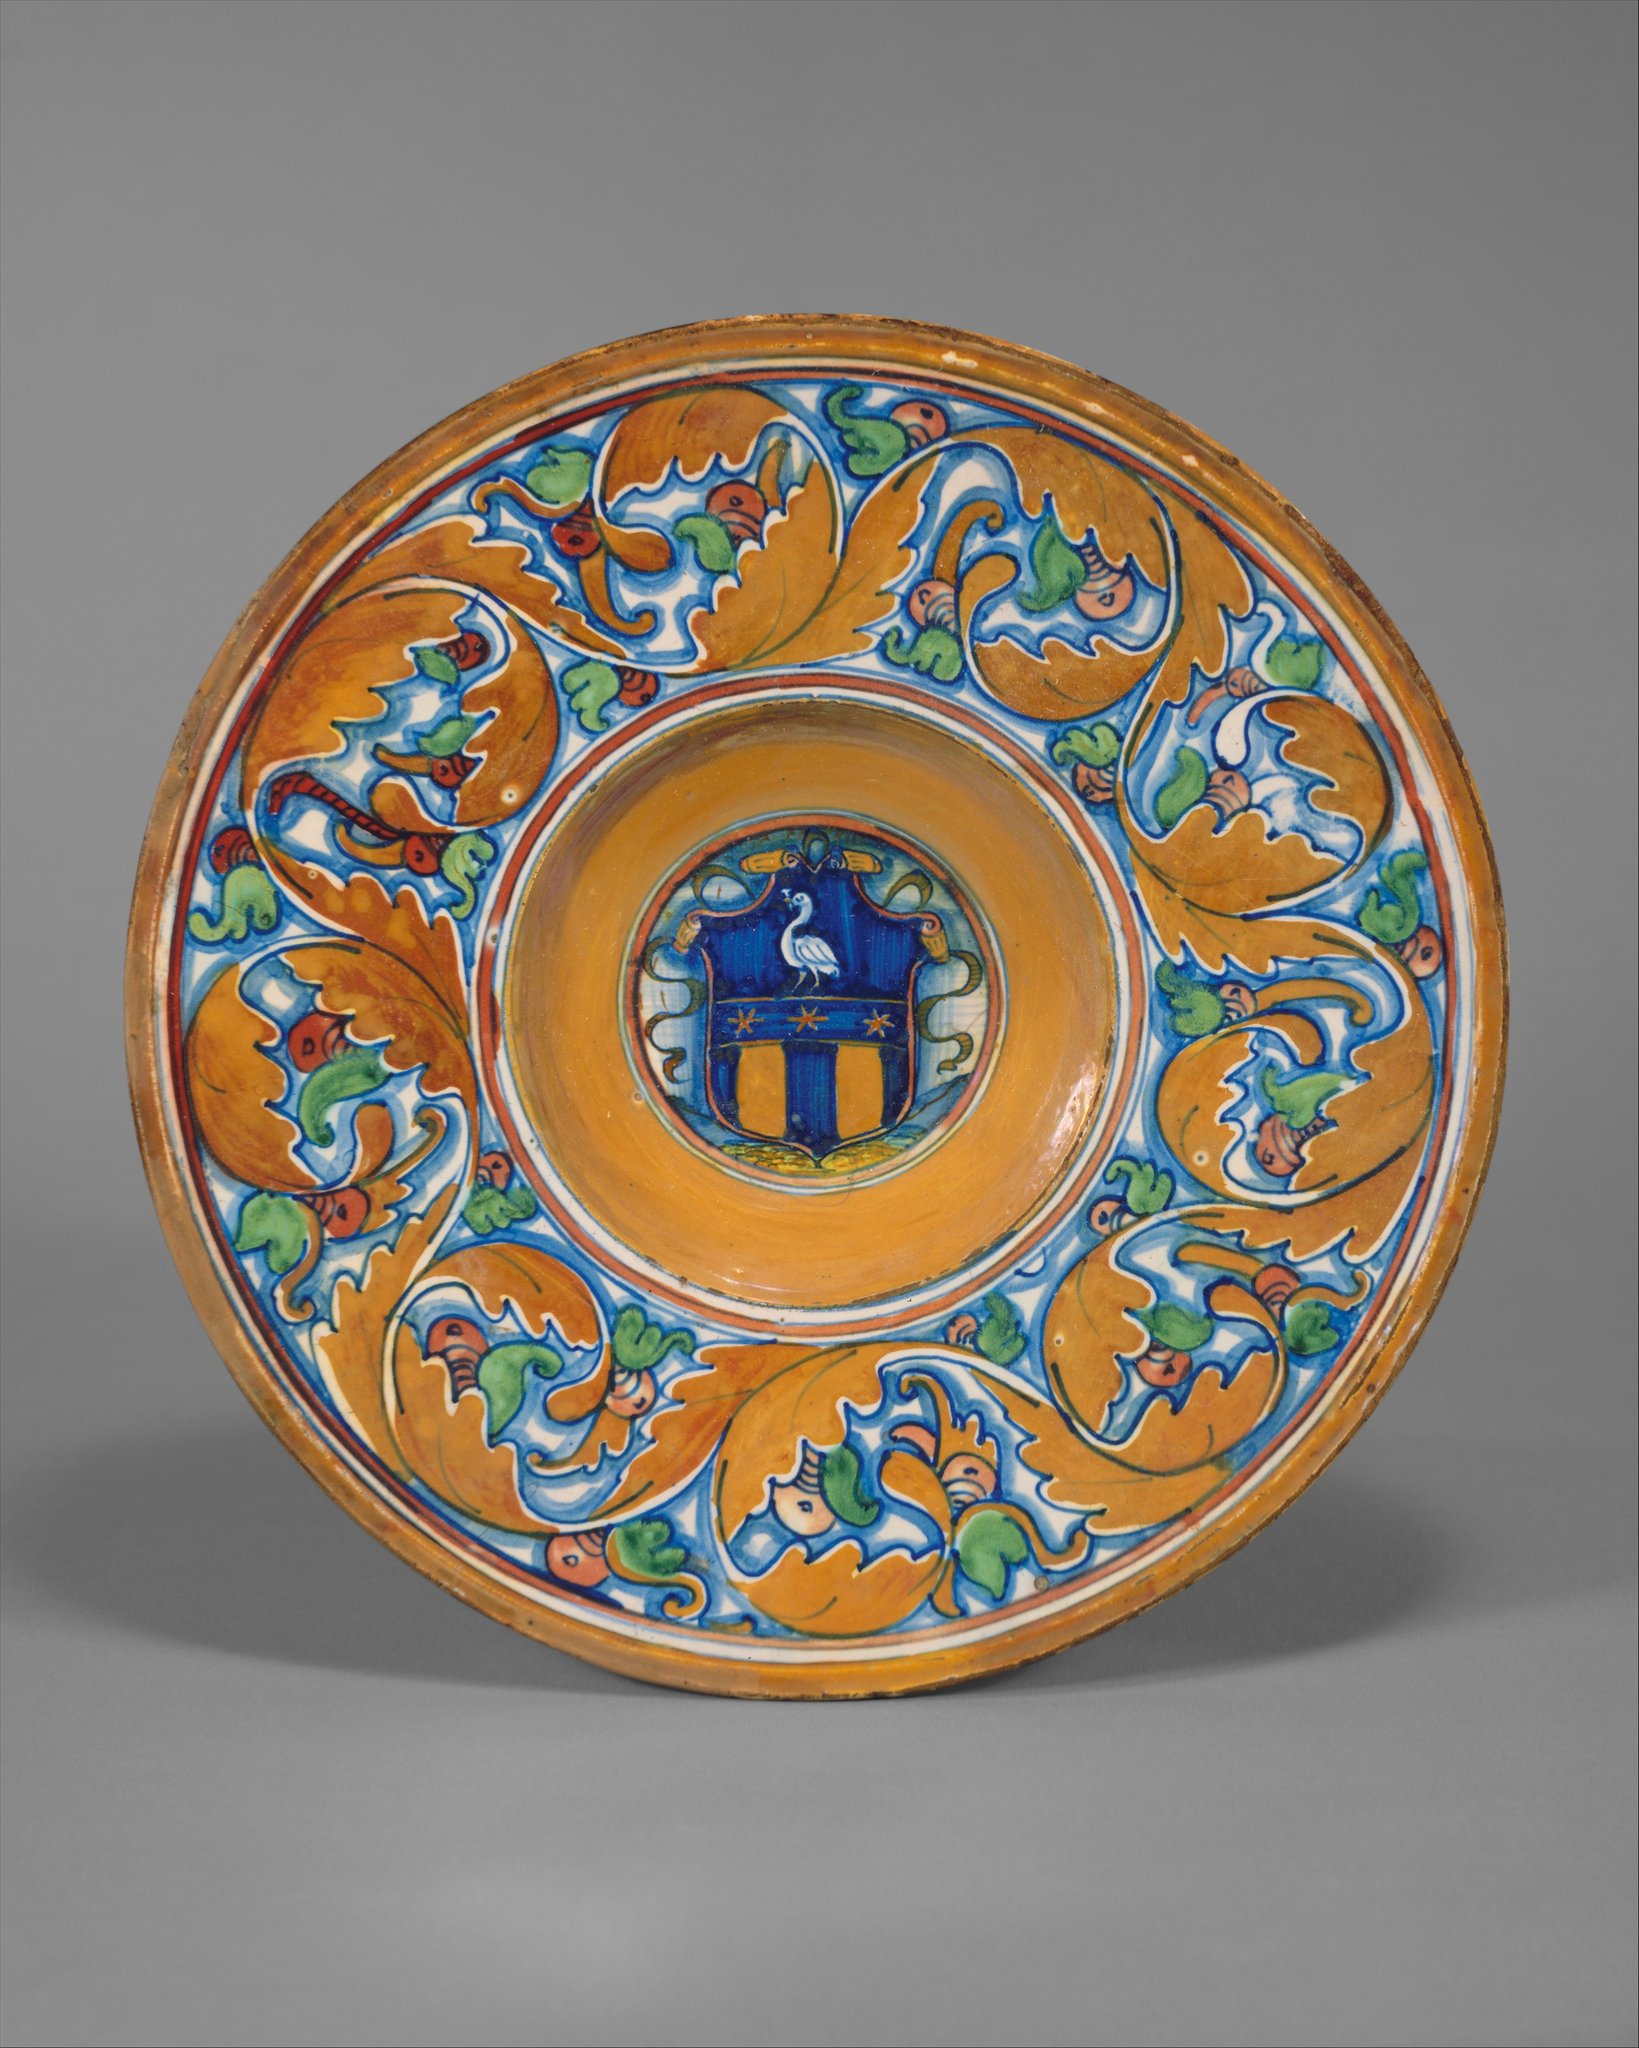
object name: plate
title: Plate (tondino)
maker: maestro giorgio andreoli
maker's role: artist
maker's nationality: italian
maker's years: 1500-1550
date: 1525-1530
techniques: maiolica, glazing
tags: coat of arms